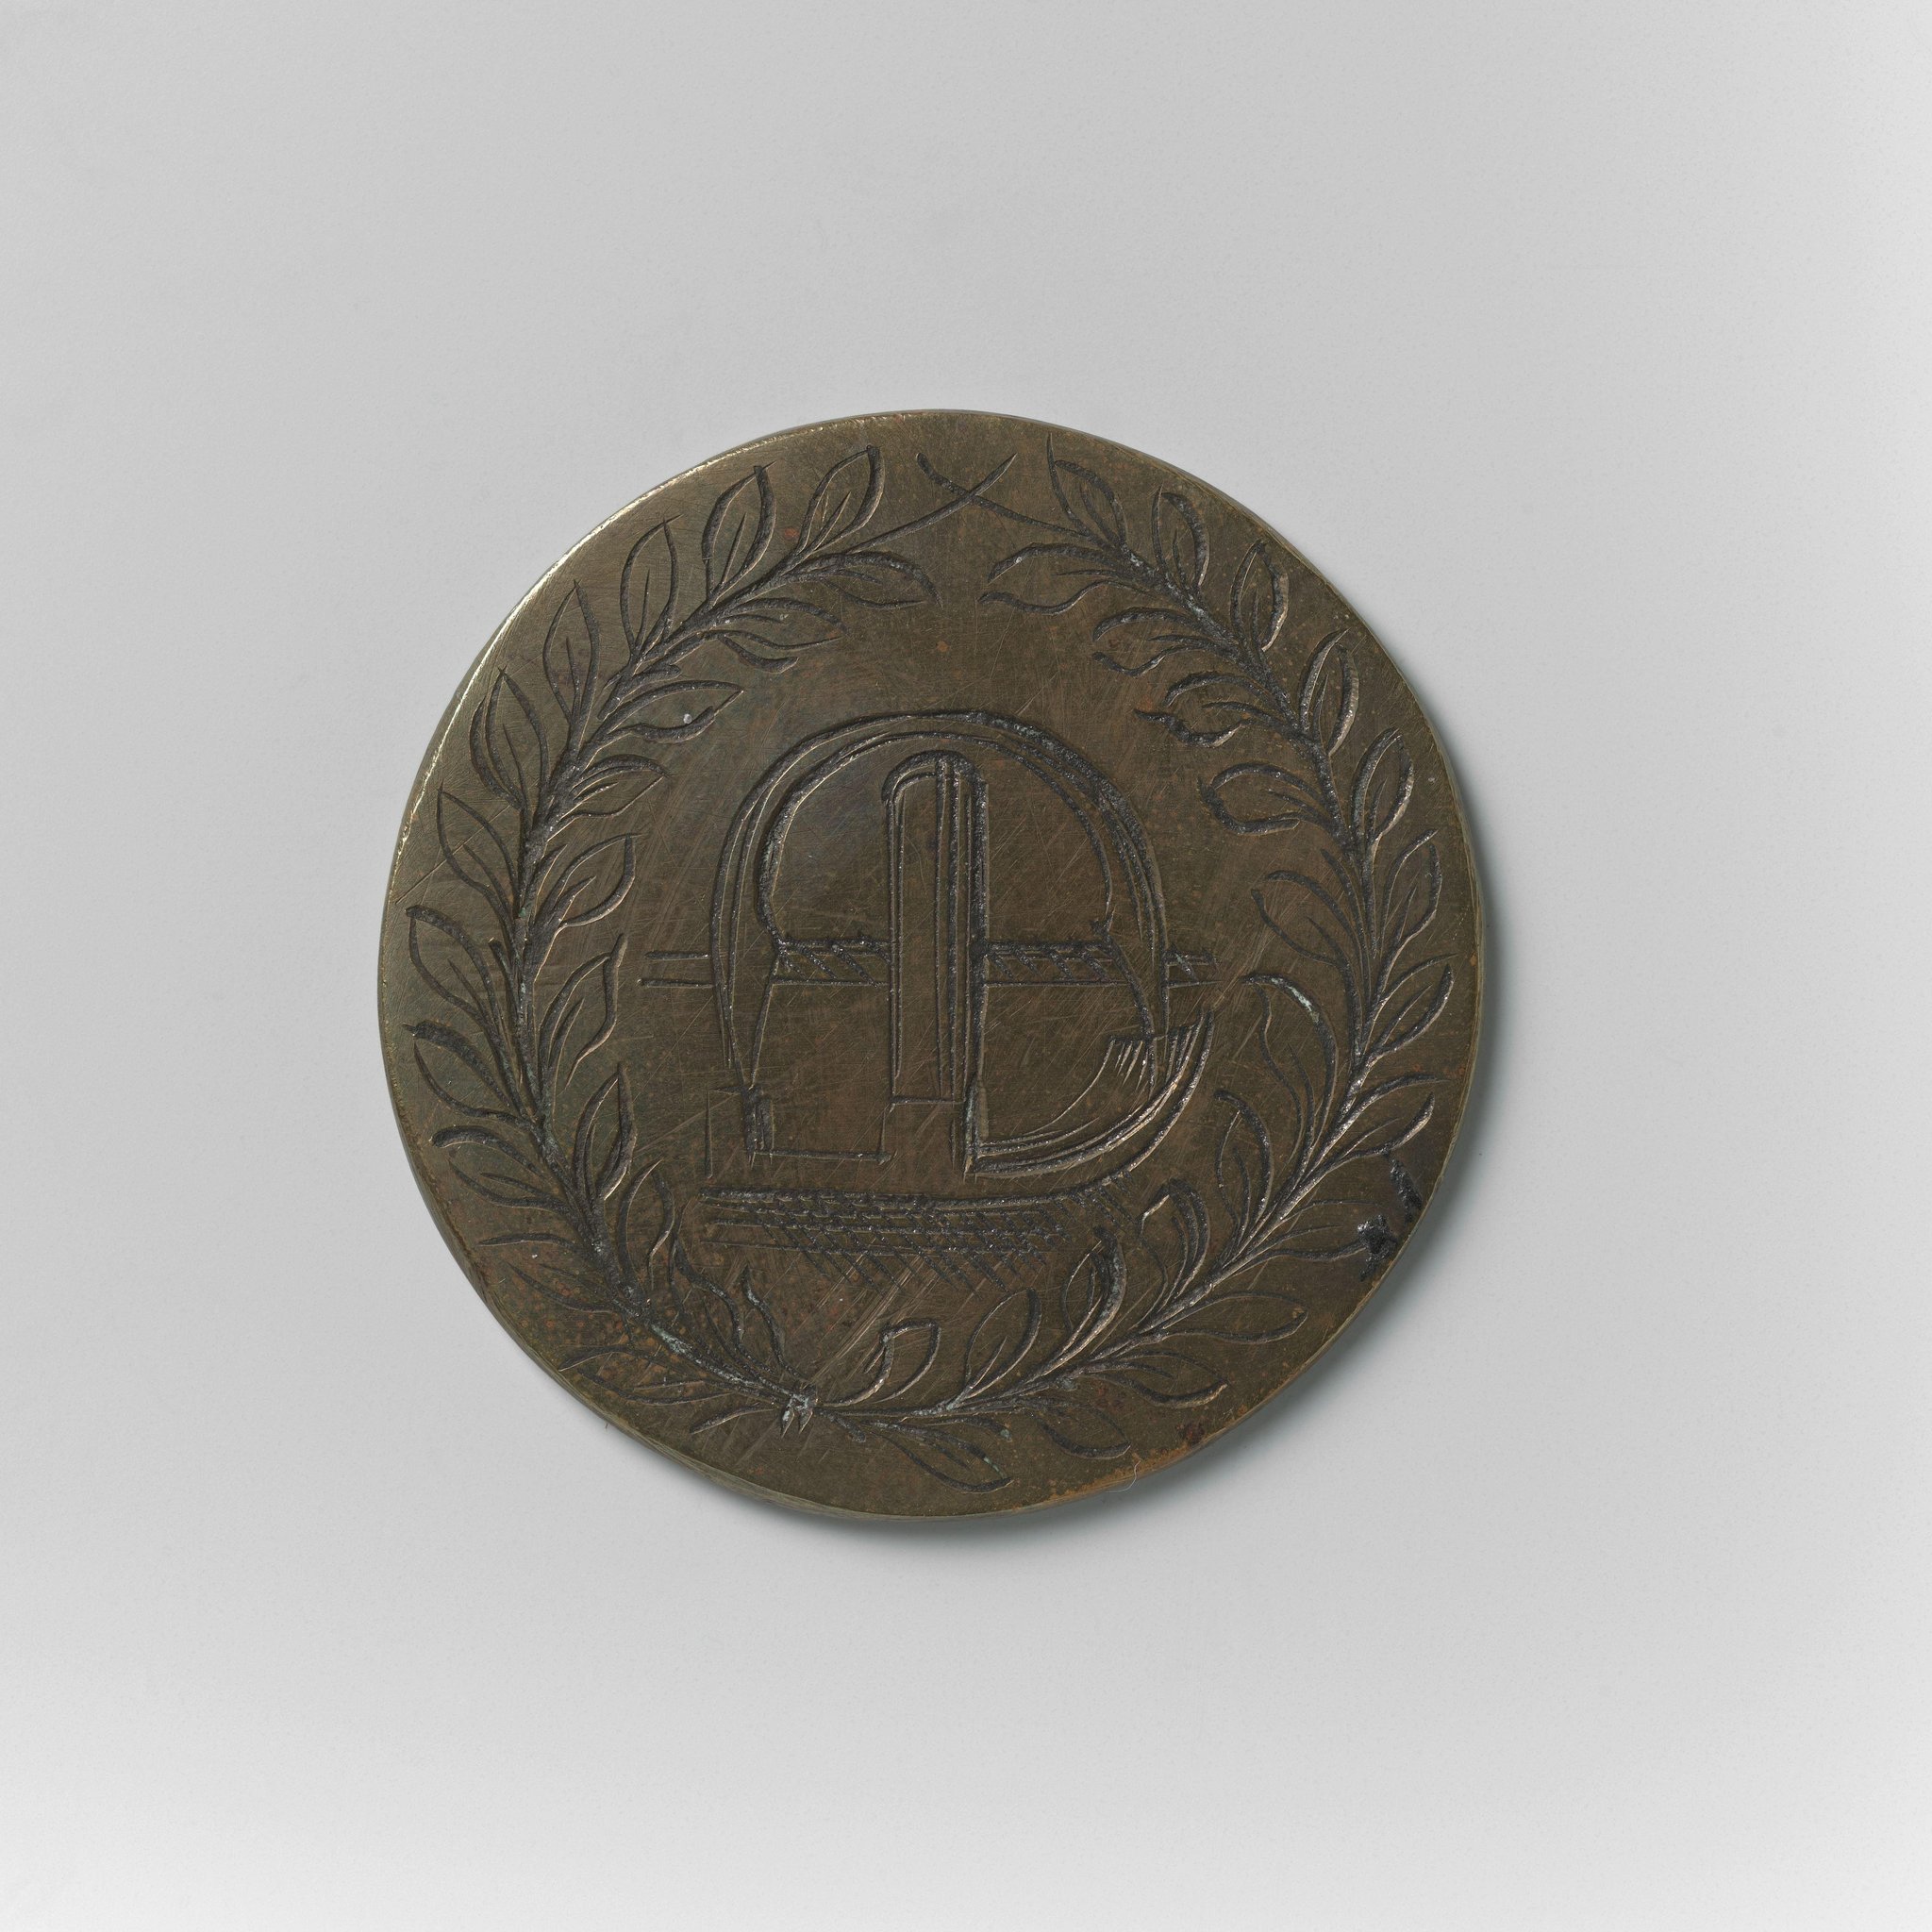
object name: history medal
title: Presentiepenning van het Kuipersgilde te Amsterdam, 1664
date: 1664-1727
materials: brass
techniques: engraving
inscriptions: inscription: ‘1727 / Jan Coerte / meijer / den 4 Septemb' / mr Kuijper’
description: Ronde plaat messing gegraveerd op de voorzijde een dissel en passer in krans, op de keerzijde vijf regels tekst, op naam van Jan Coertemeijer 4 september 1727